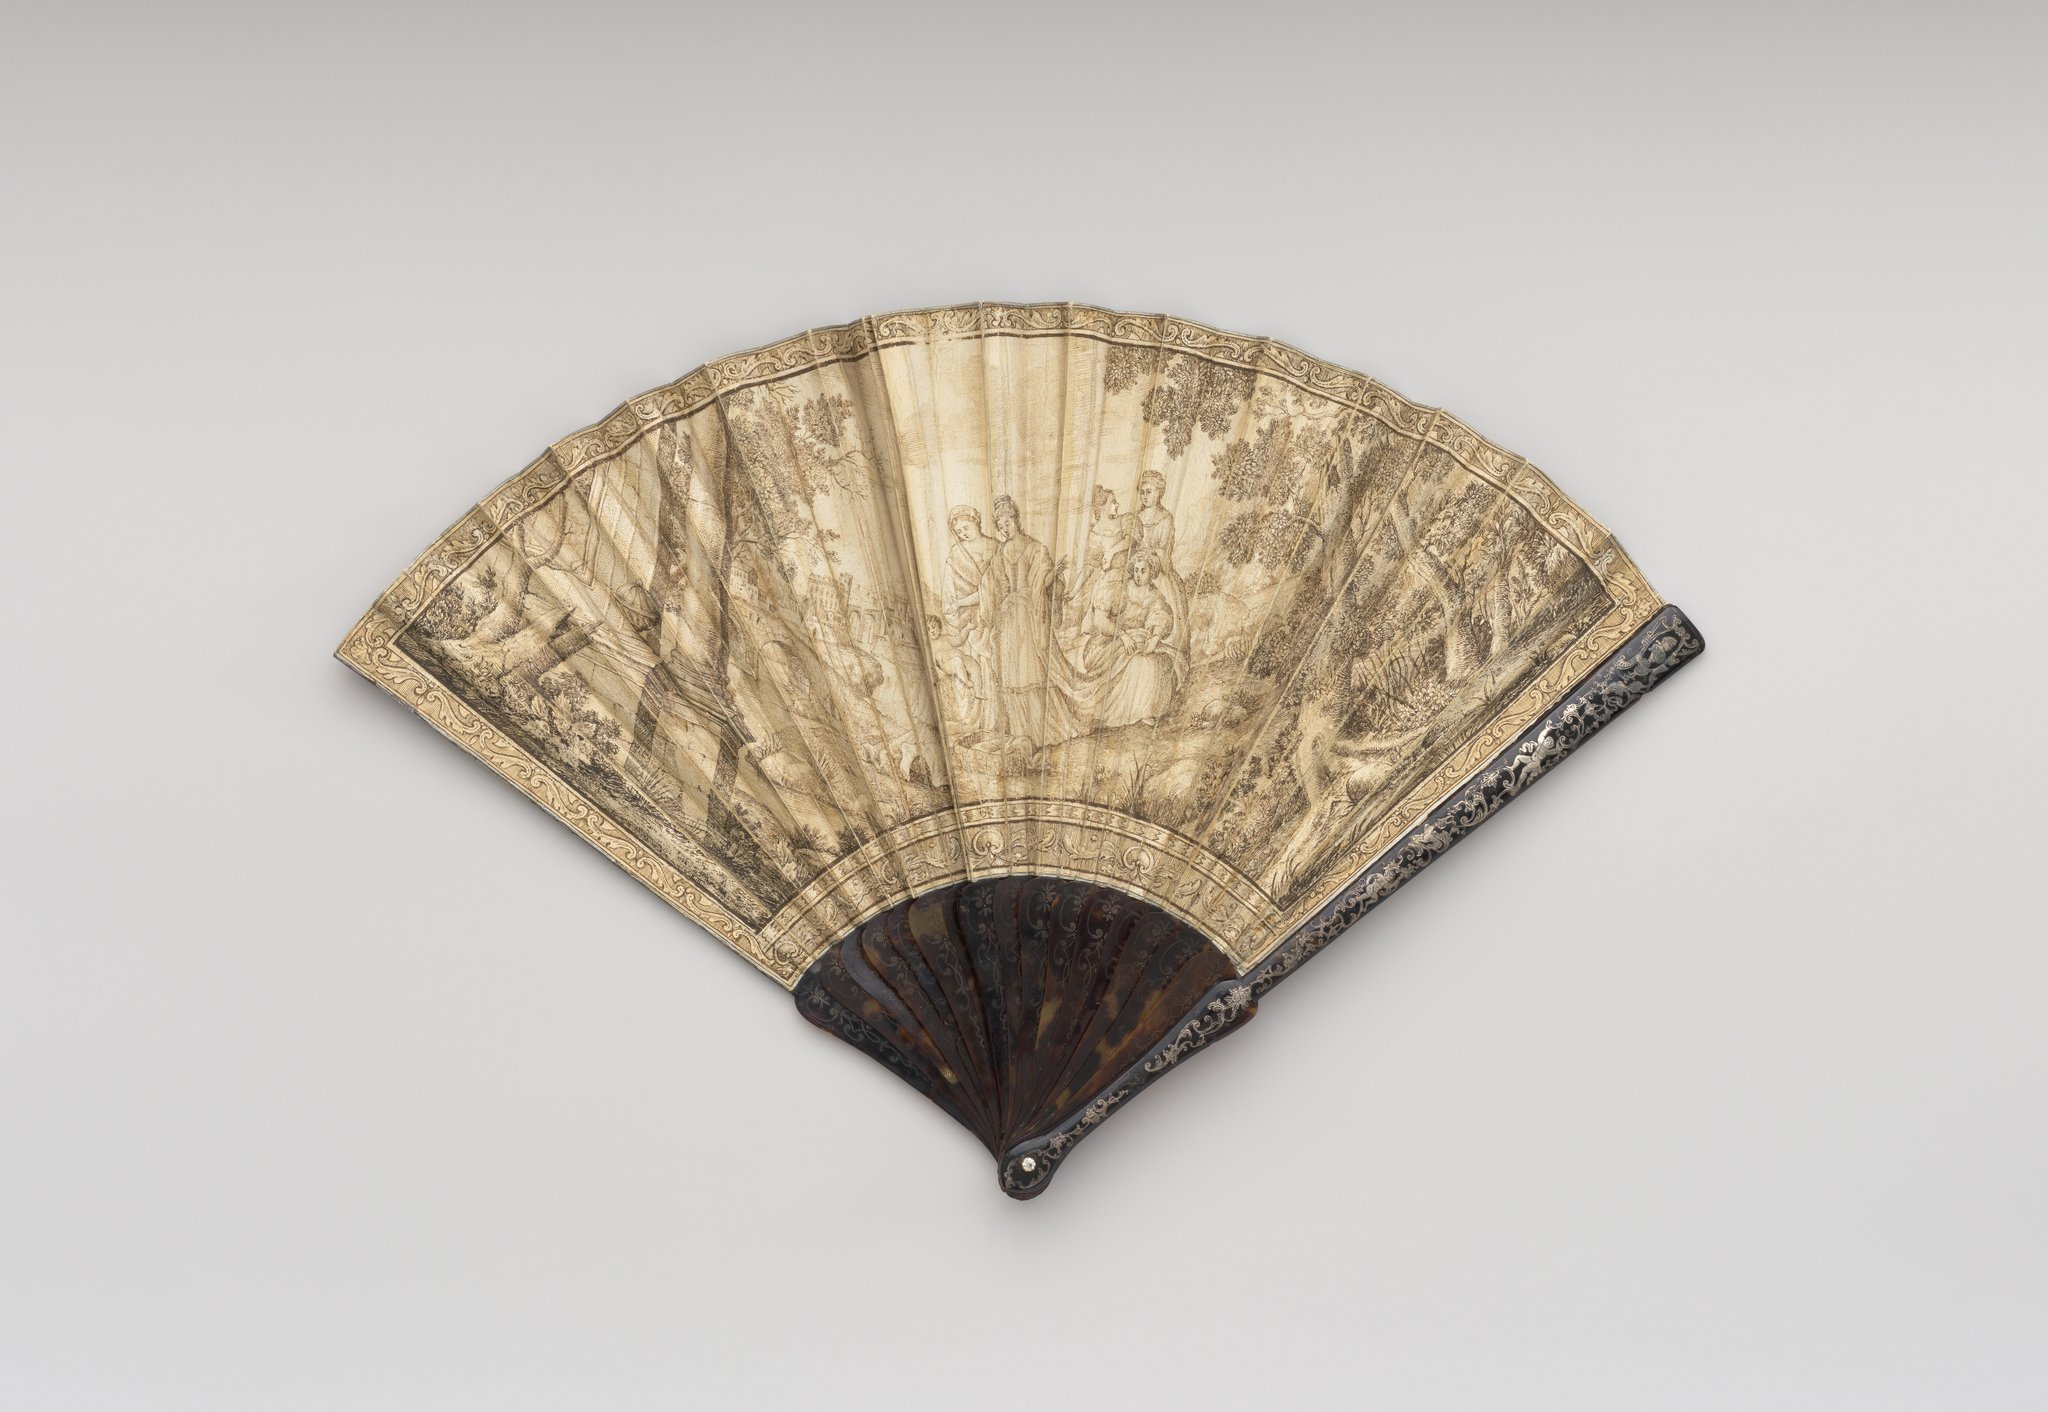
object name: fan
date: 1701-1750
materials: silver, skin, shell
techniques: inlay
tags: infants,women